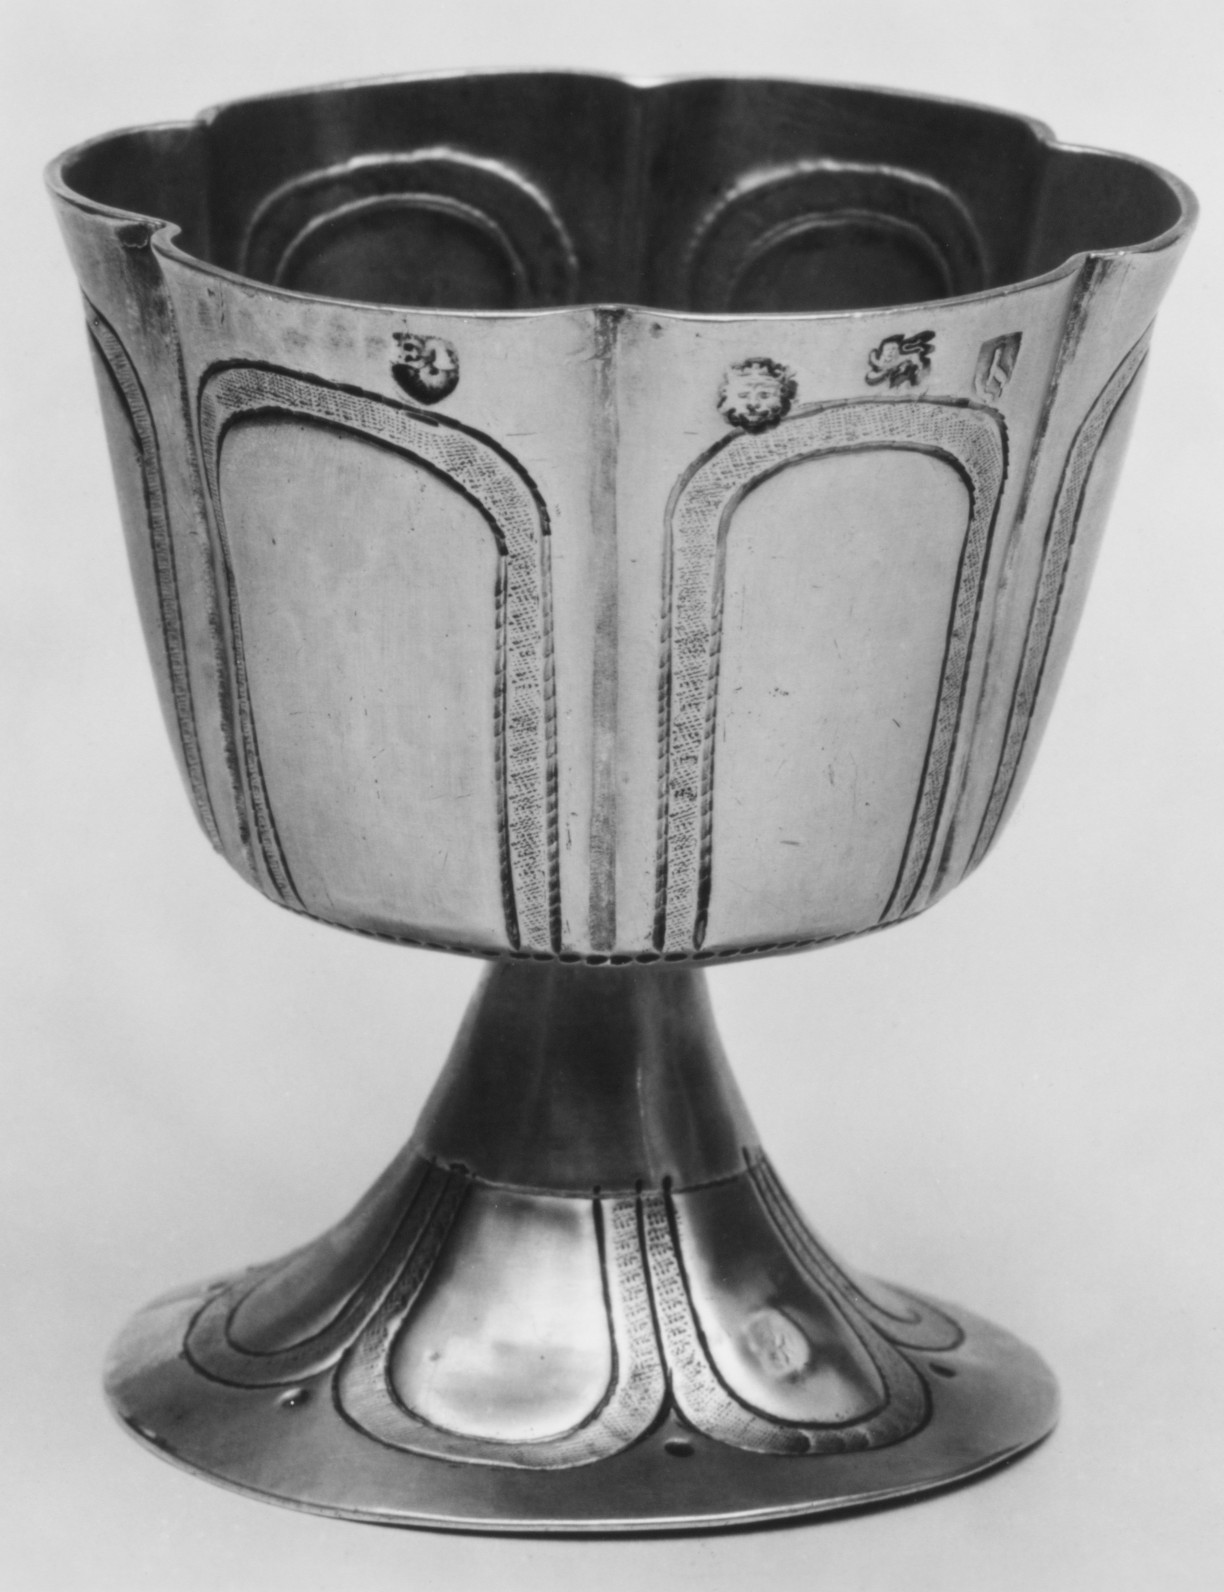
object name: wine cup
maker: e. t., london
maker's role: maker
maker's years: 1653-1663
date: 1653-1654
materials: silver gilt